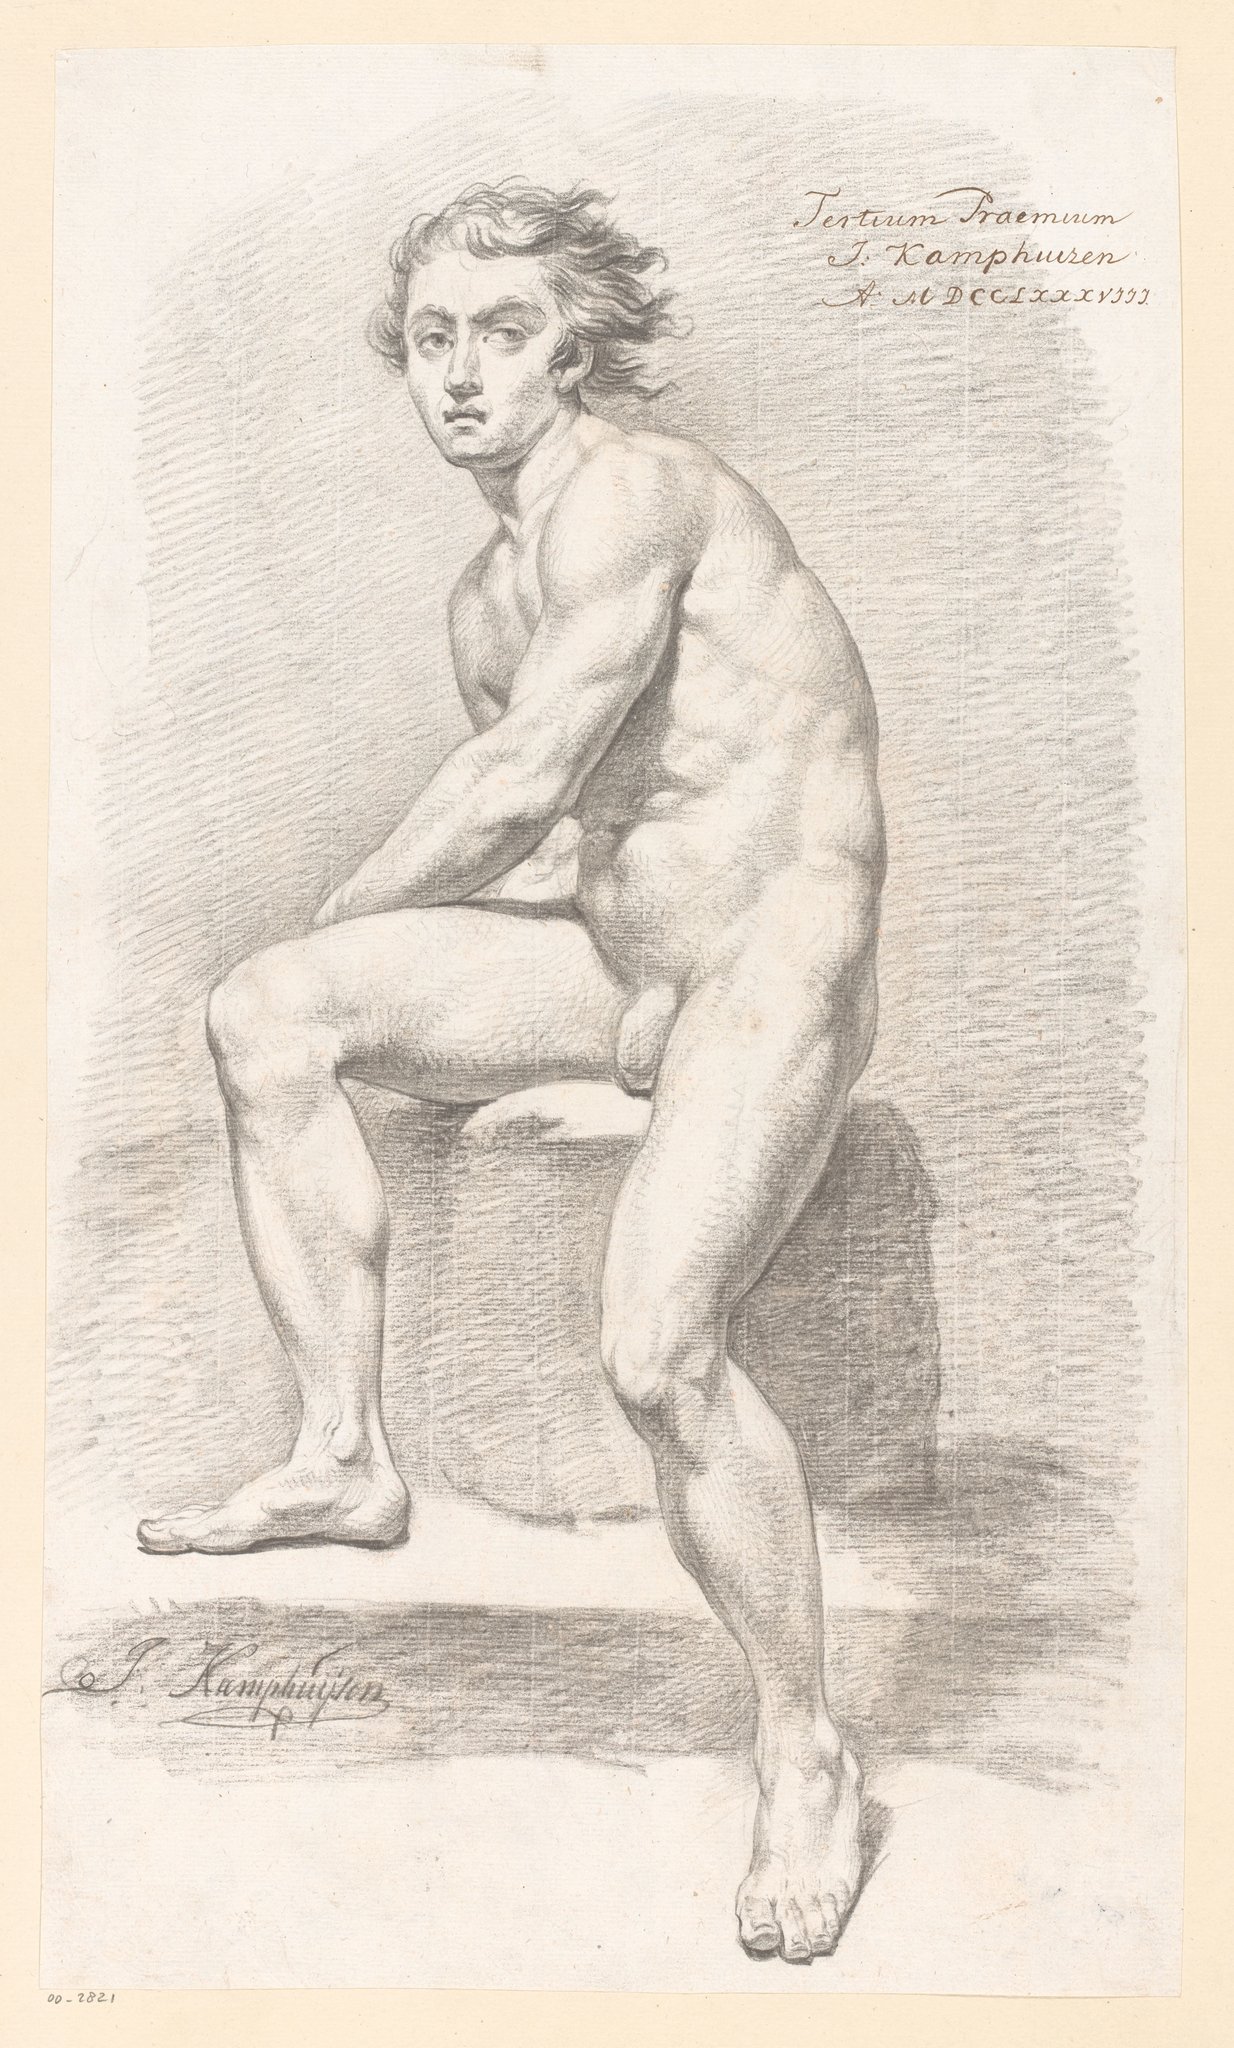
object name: drawing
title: Zittend mannelijk naakt, van voren gezien (3e prijs 1788)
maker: jan kamphuijsen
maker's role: draughtsman, painter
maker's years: 1760-1841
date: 1788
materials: chalk, paper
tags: sitting figure (+ nude human being)